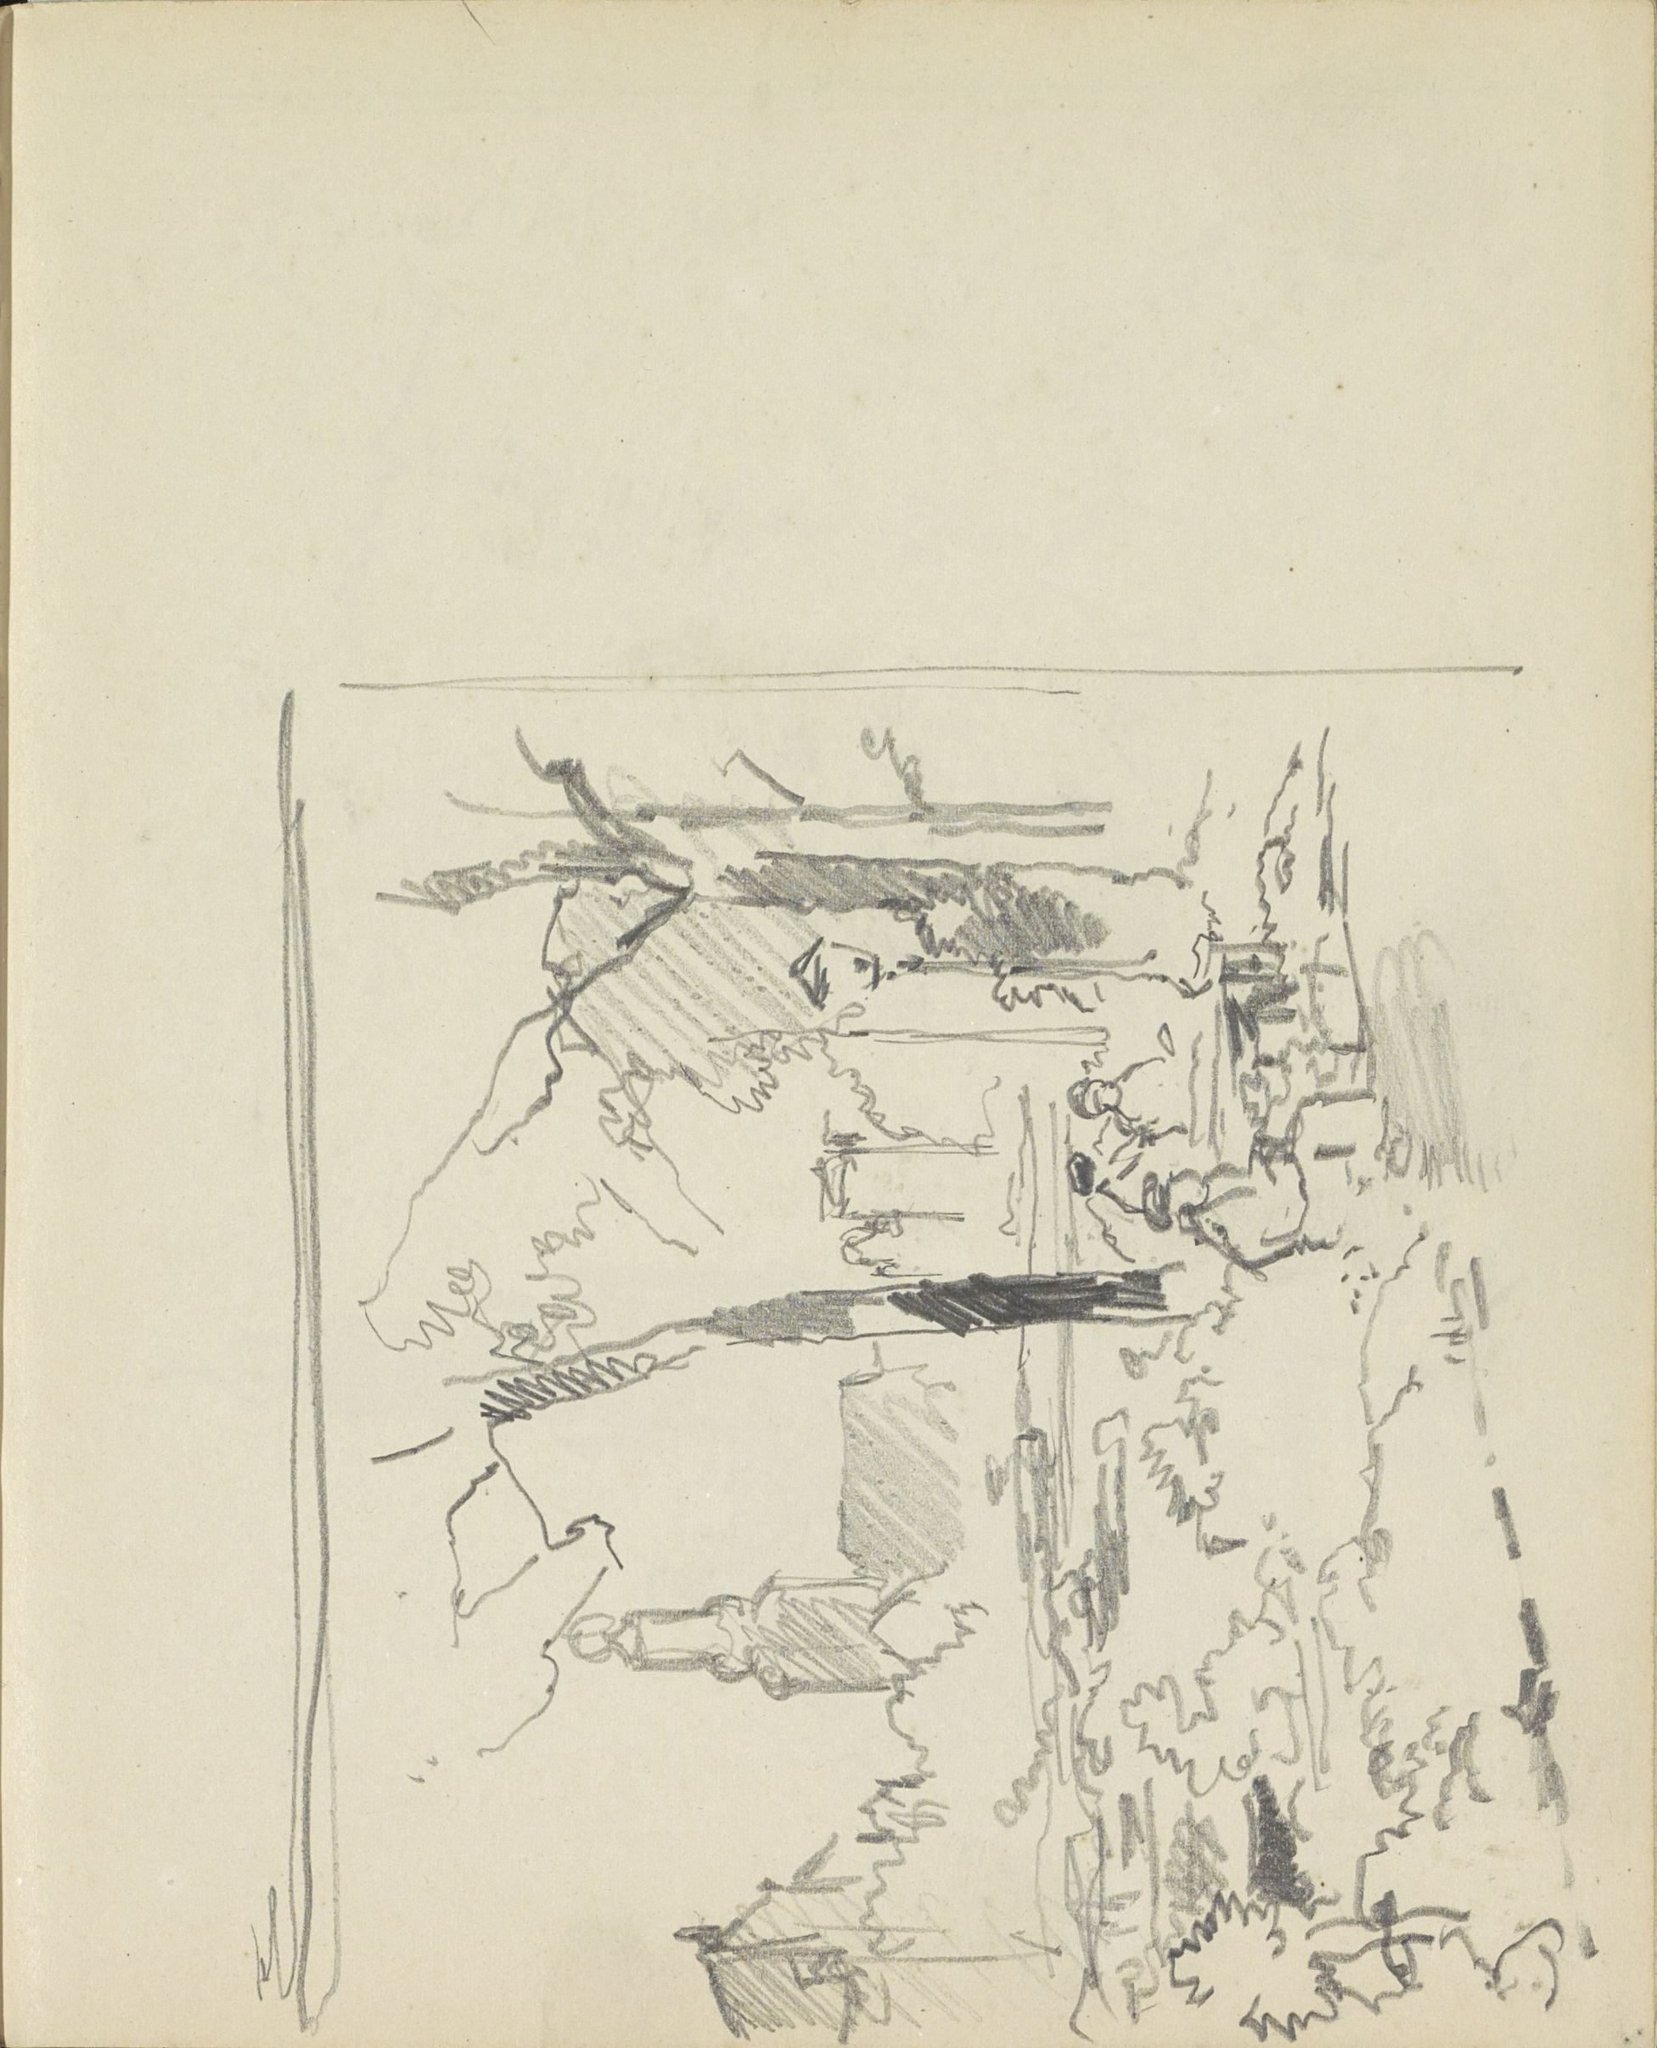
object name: sketchbook leaf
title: Figuren bij de kade van het Singel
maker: cornelis vreedenburgh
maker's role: draughtsman, print maker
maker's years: 1880-1946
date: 1890-1946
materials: paper, pencil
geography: amsterdam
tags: canals, waters (in city), quay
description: Op de achtergrond de Munttoren. Blad 18 recto uit een schetsboek met 76 bladen.